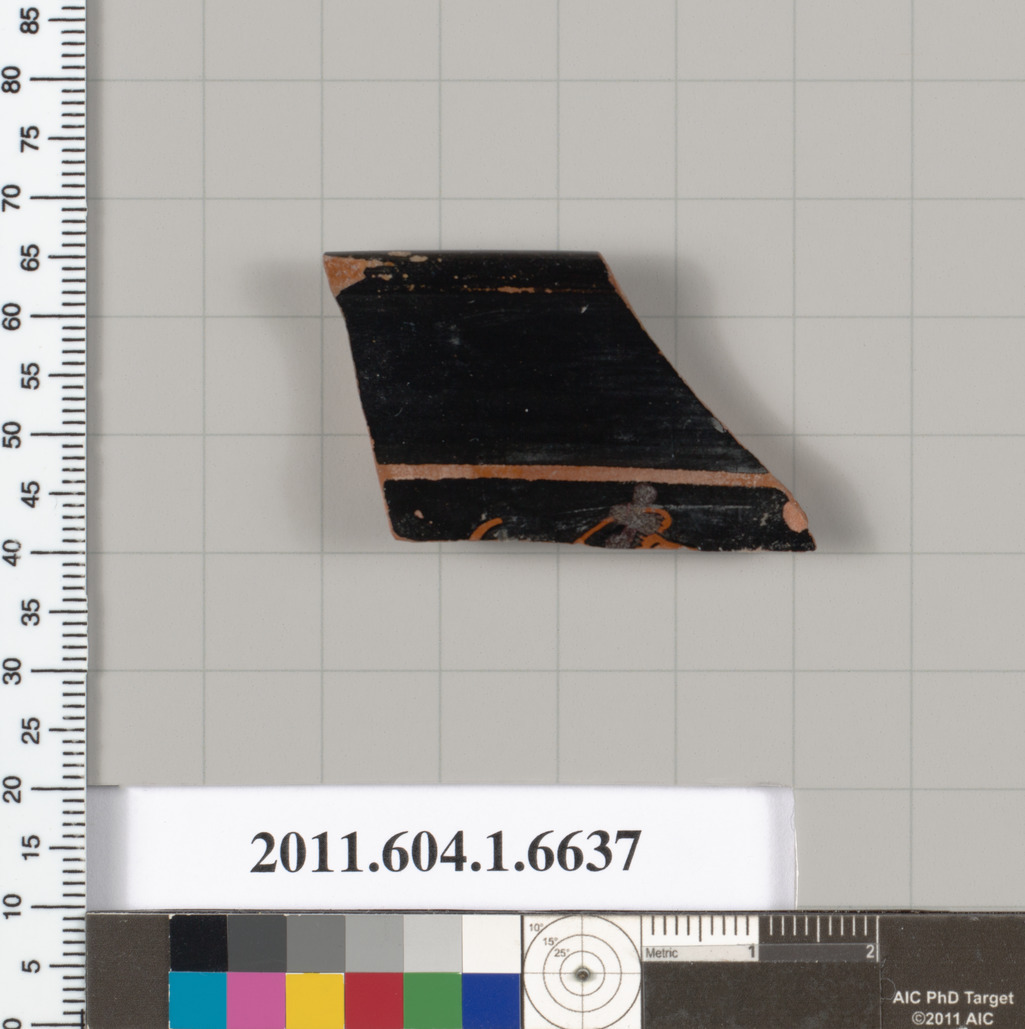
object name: kylix fragment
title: Terracotta rim fragment of a kylix (drinking cup)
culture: greek, attic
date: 490-470 BCE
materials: terracotta